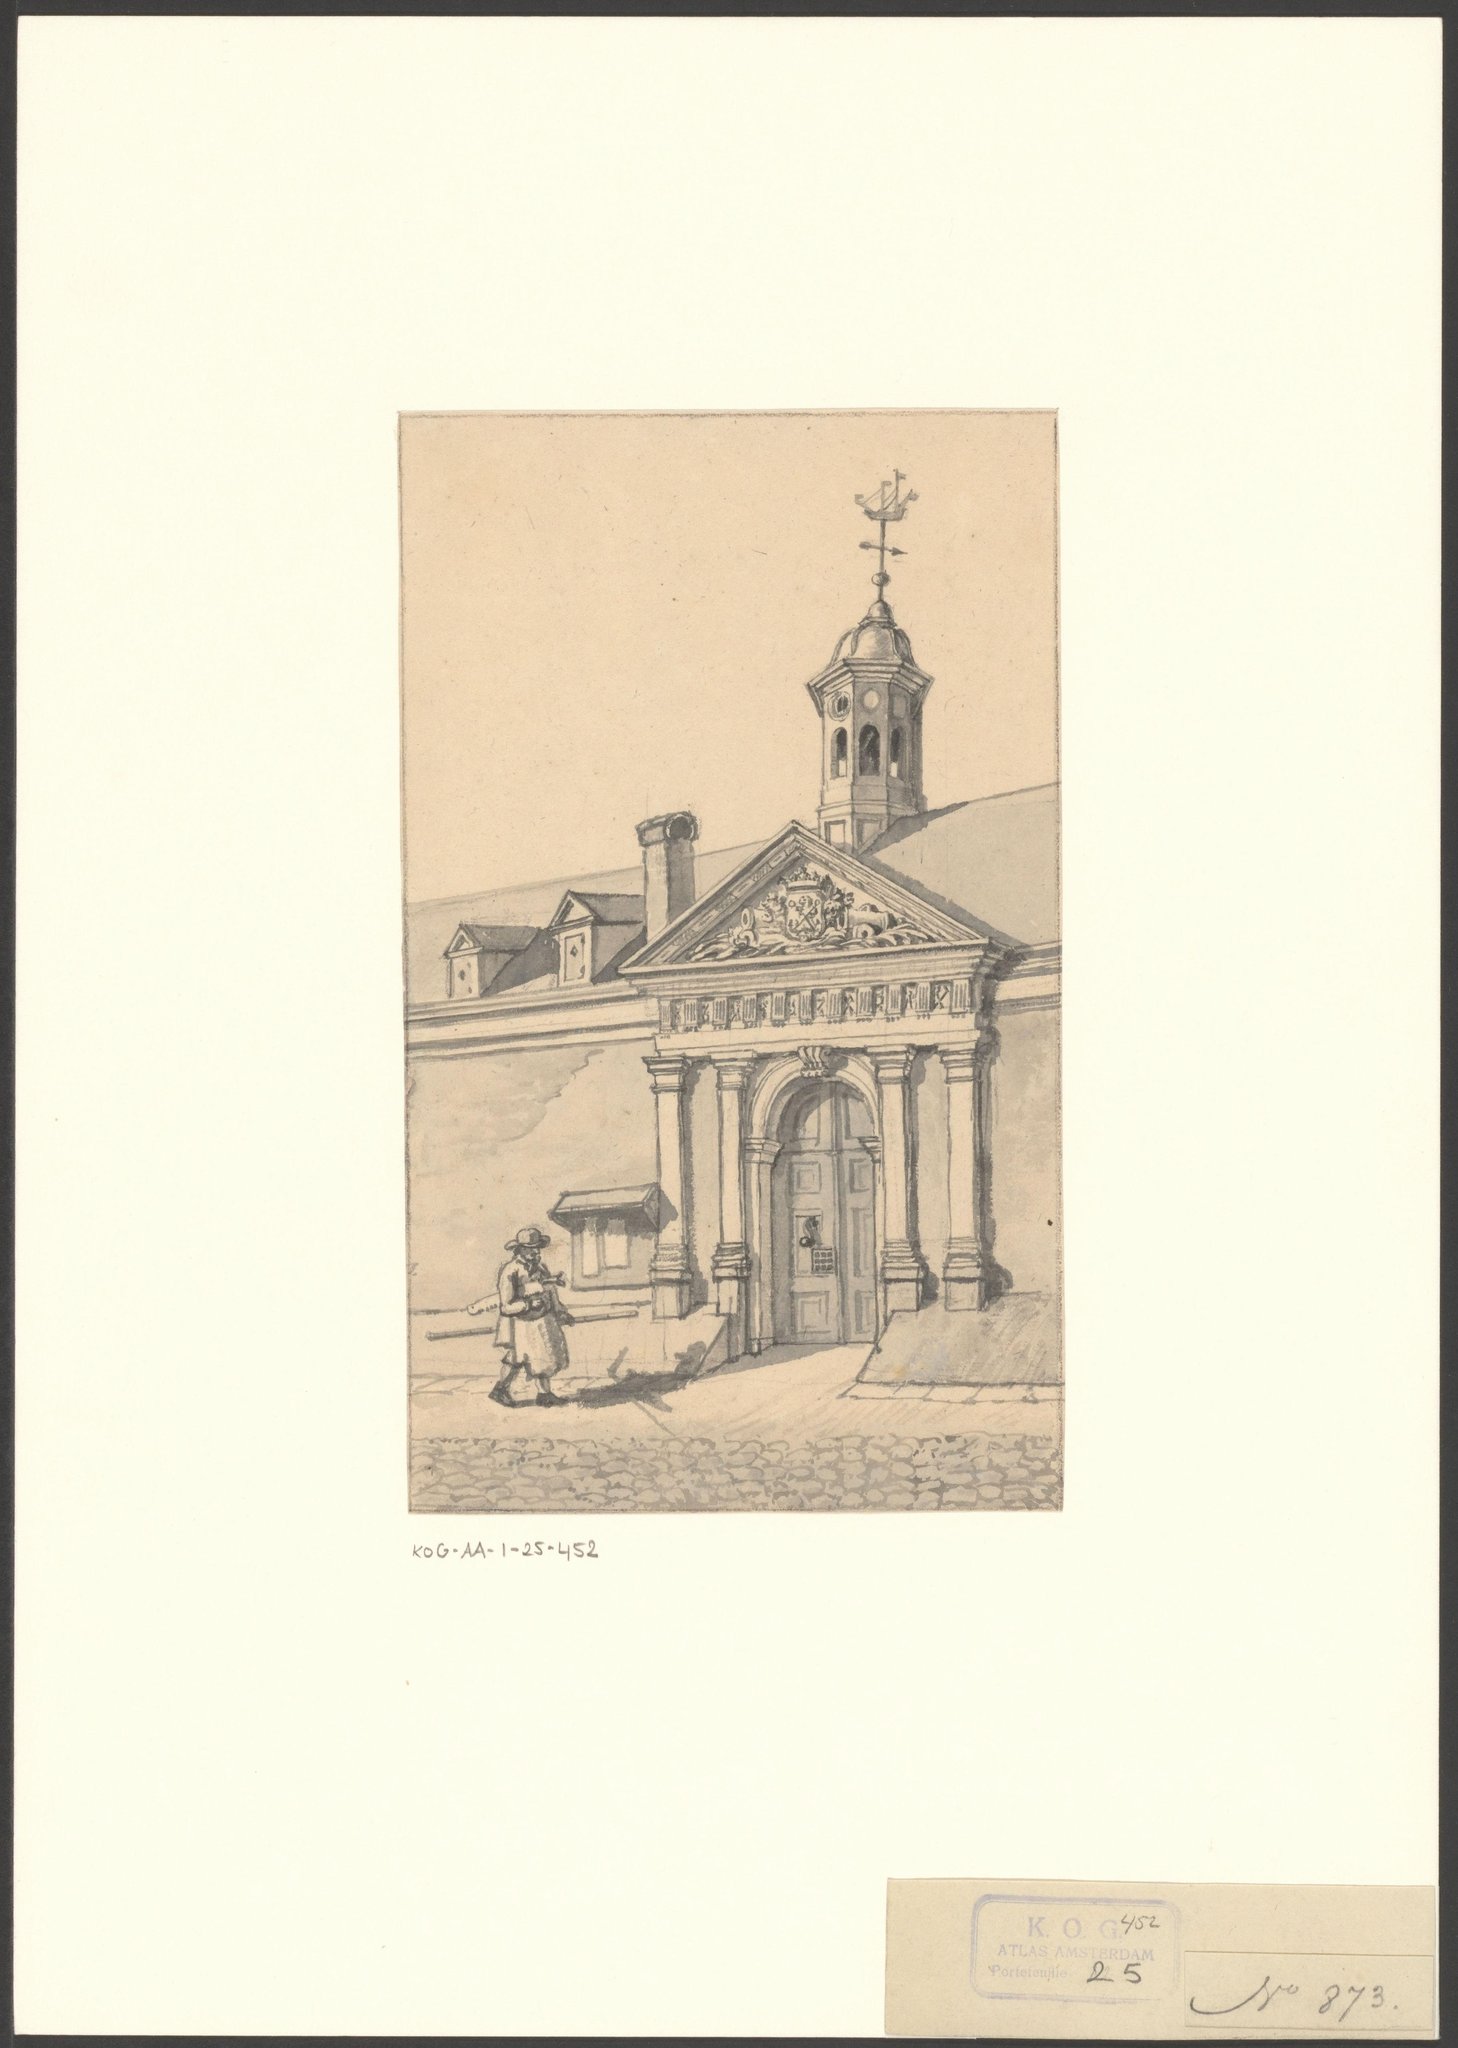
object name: drawing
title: Gezicht op de ingang van 's Lands Werf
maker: gerrit lamberts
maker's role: bookseller, draughtsman, print maker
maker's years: 1776-1850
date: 1816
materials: chalk, ink, paper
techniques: brush, pen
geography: amsterdam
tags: city-view in general; 'veduta', gate, entrance, shipyard, shipdock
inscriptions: signature, date and inscription: ‘Ingang van de (...) G. Lamberts. f. 1816.’, collector's mark: ‘25’ Lugt 1641b, inscription: ‘Port. 25-452’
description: Onderwerpsrubriek binnen de Atlas Amsterdam: Admiraliteitsgebouwen.